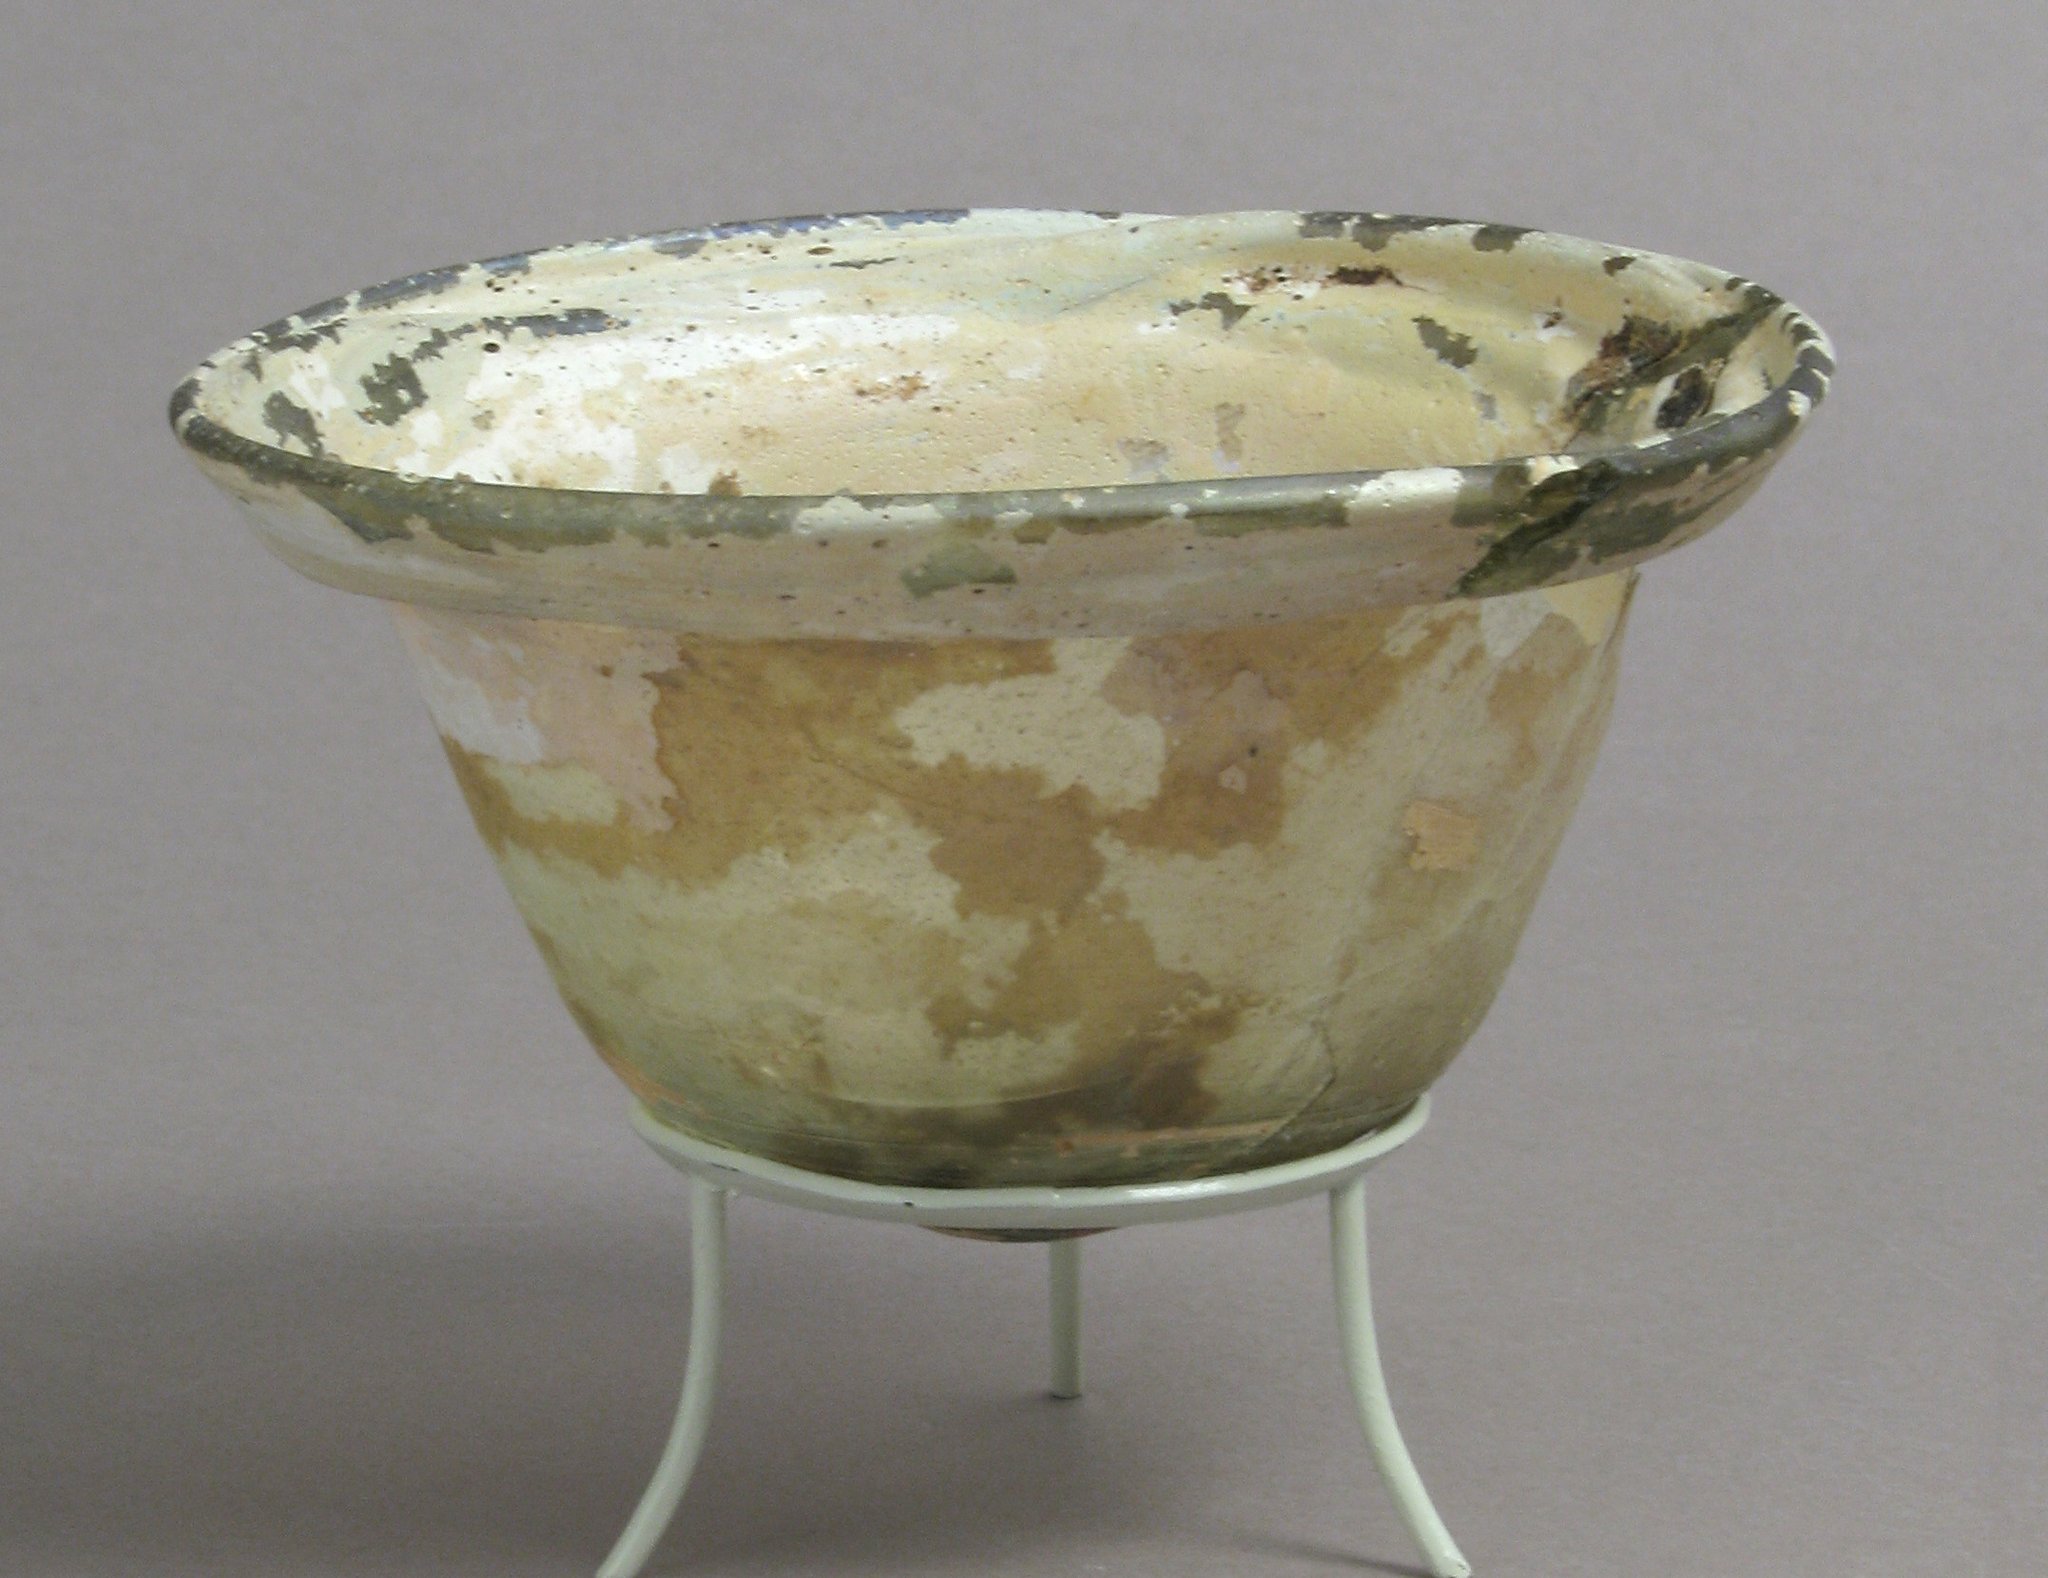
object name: cup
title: Palm Cup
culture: frankish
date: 601-800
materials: glass